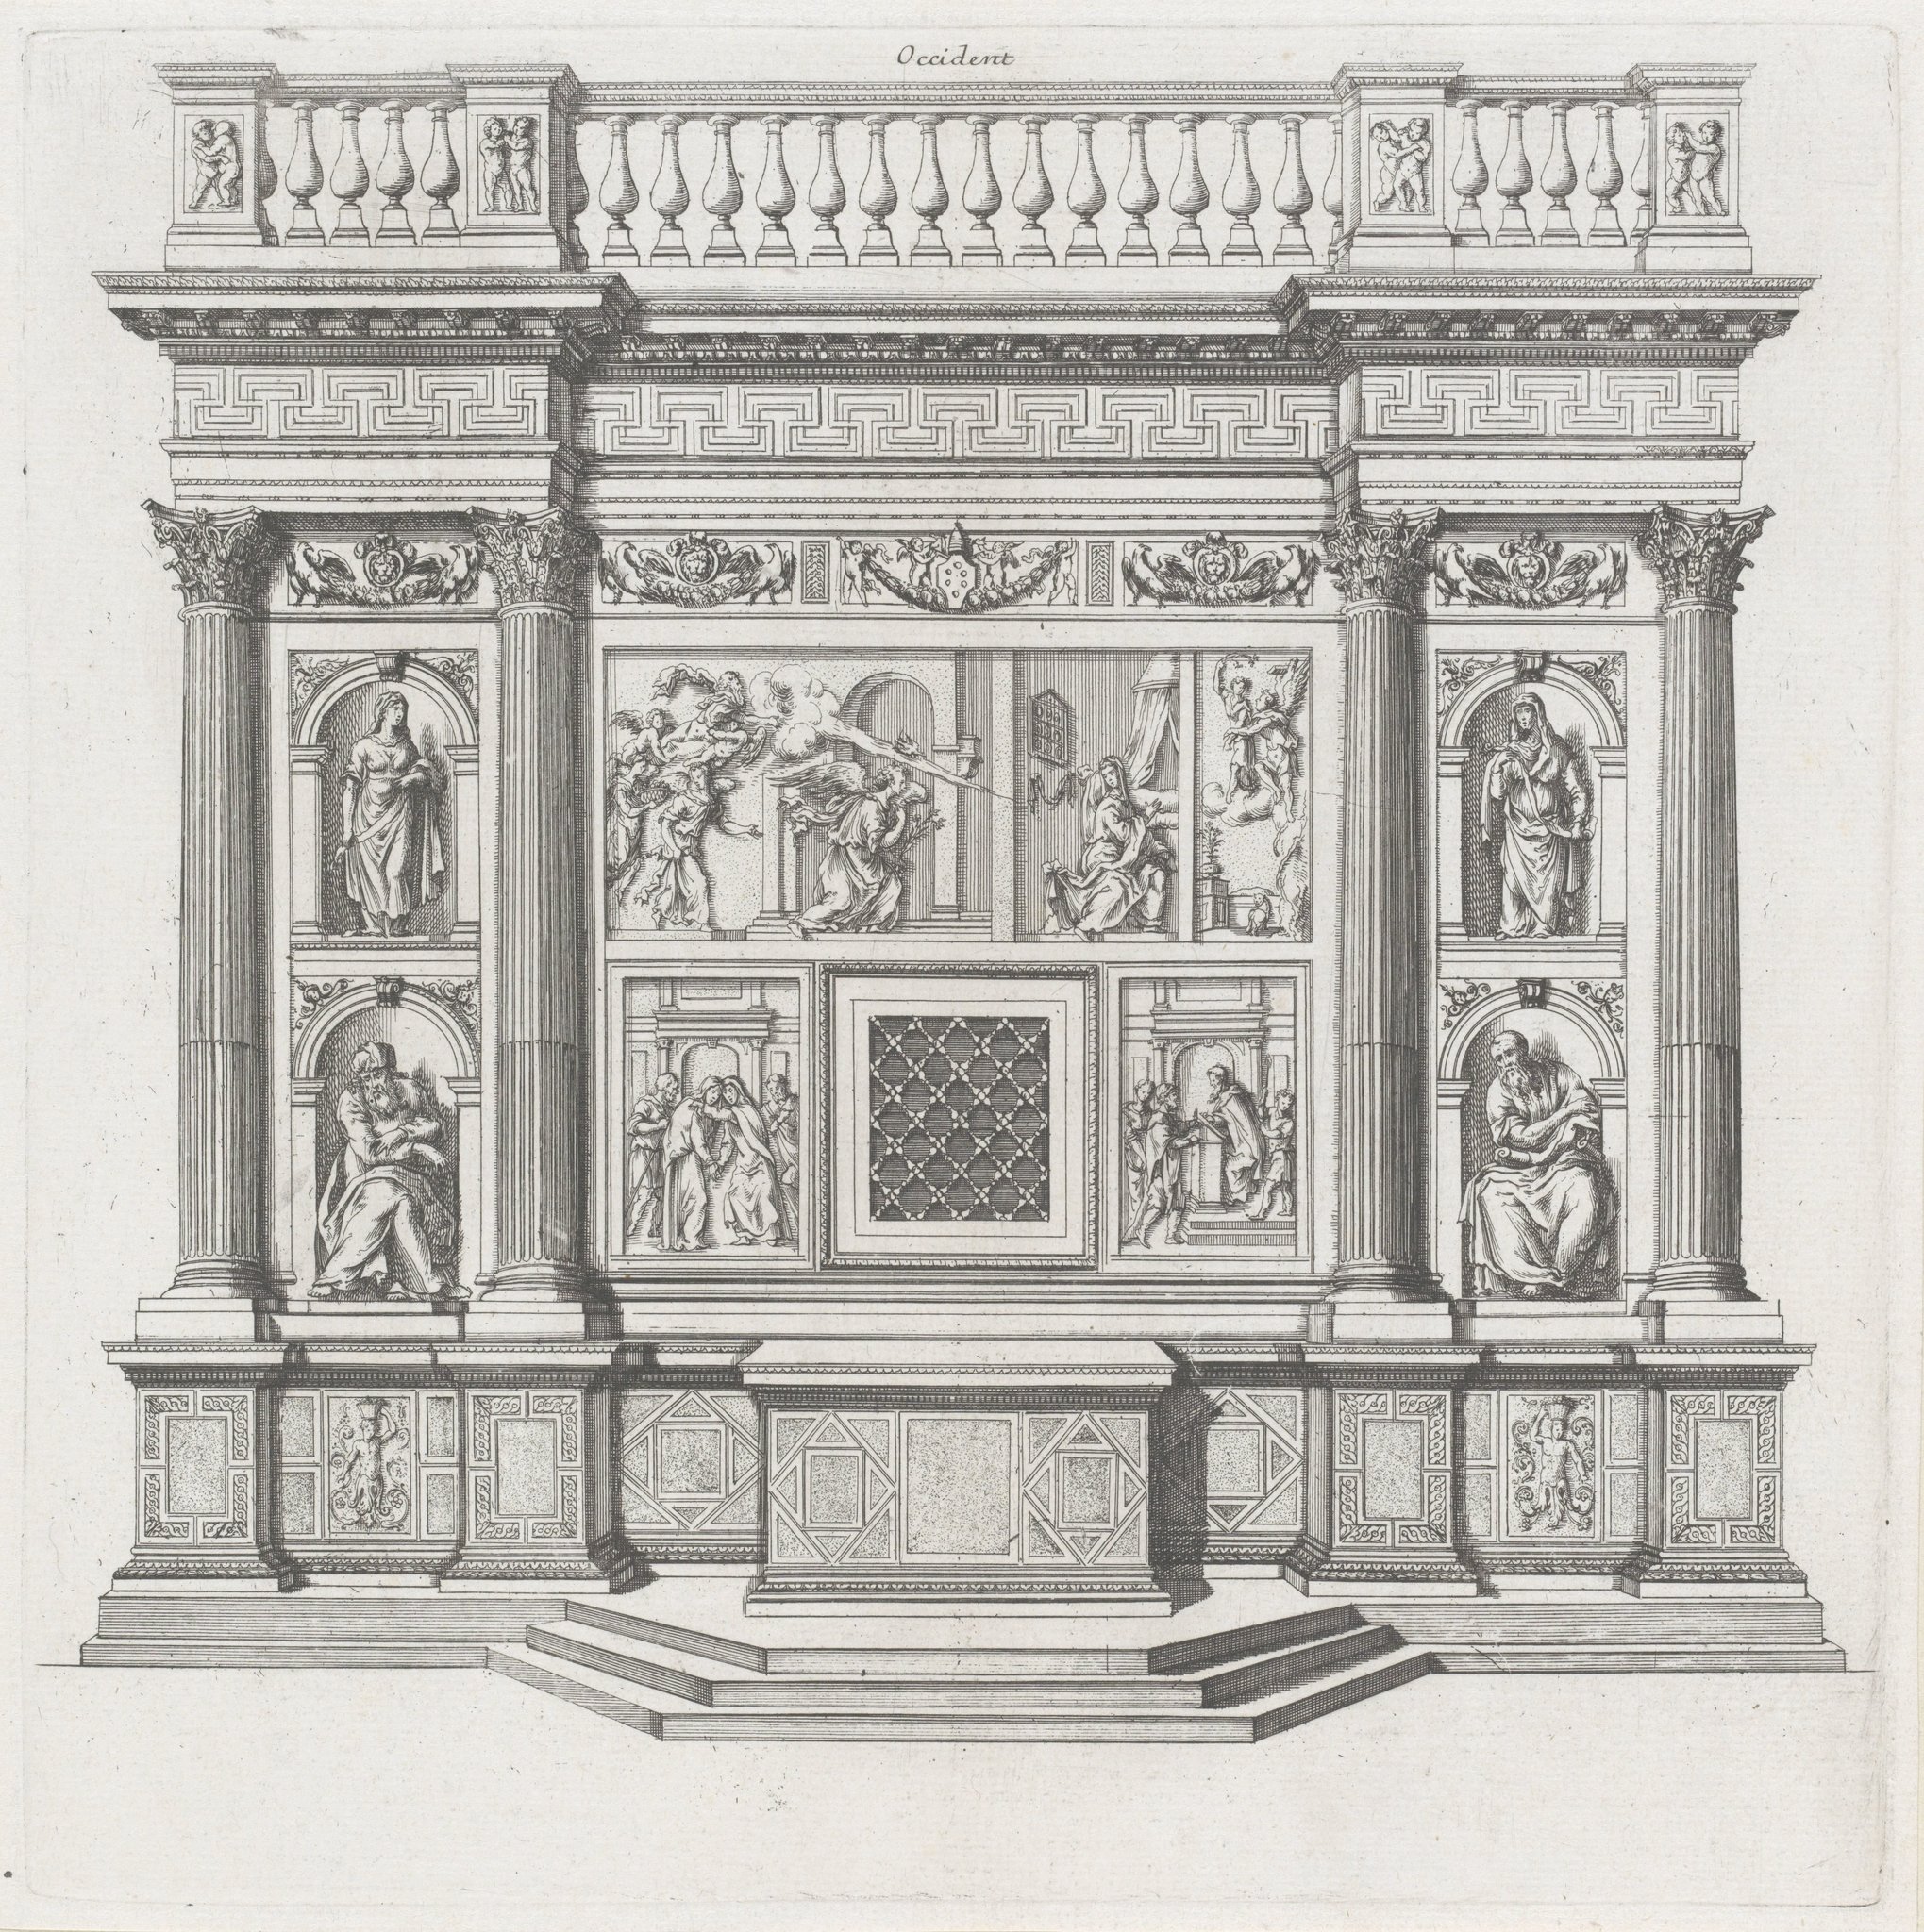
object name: print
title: Heilig Huis van de Maagd Maria, occident-zijde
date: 1649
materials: paper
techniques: etching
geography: paris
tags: parts of church interior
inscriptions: collector's mark: Lugt 240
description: De occident-zijde van de marmeren renaissance behuizing van het Heilig Huis van de Maagd Maria in de Basilica della Casa Santa in Loreto. De behuizing bevat beelden en reliëfs door Andrea Sansovino, Ranieri Nerucci en Antonio da Sangallo de Jongere. Het geheel is ontworpen door Donato Bramante.